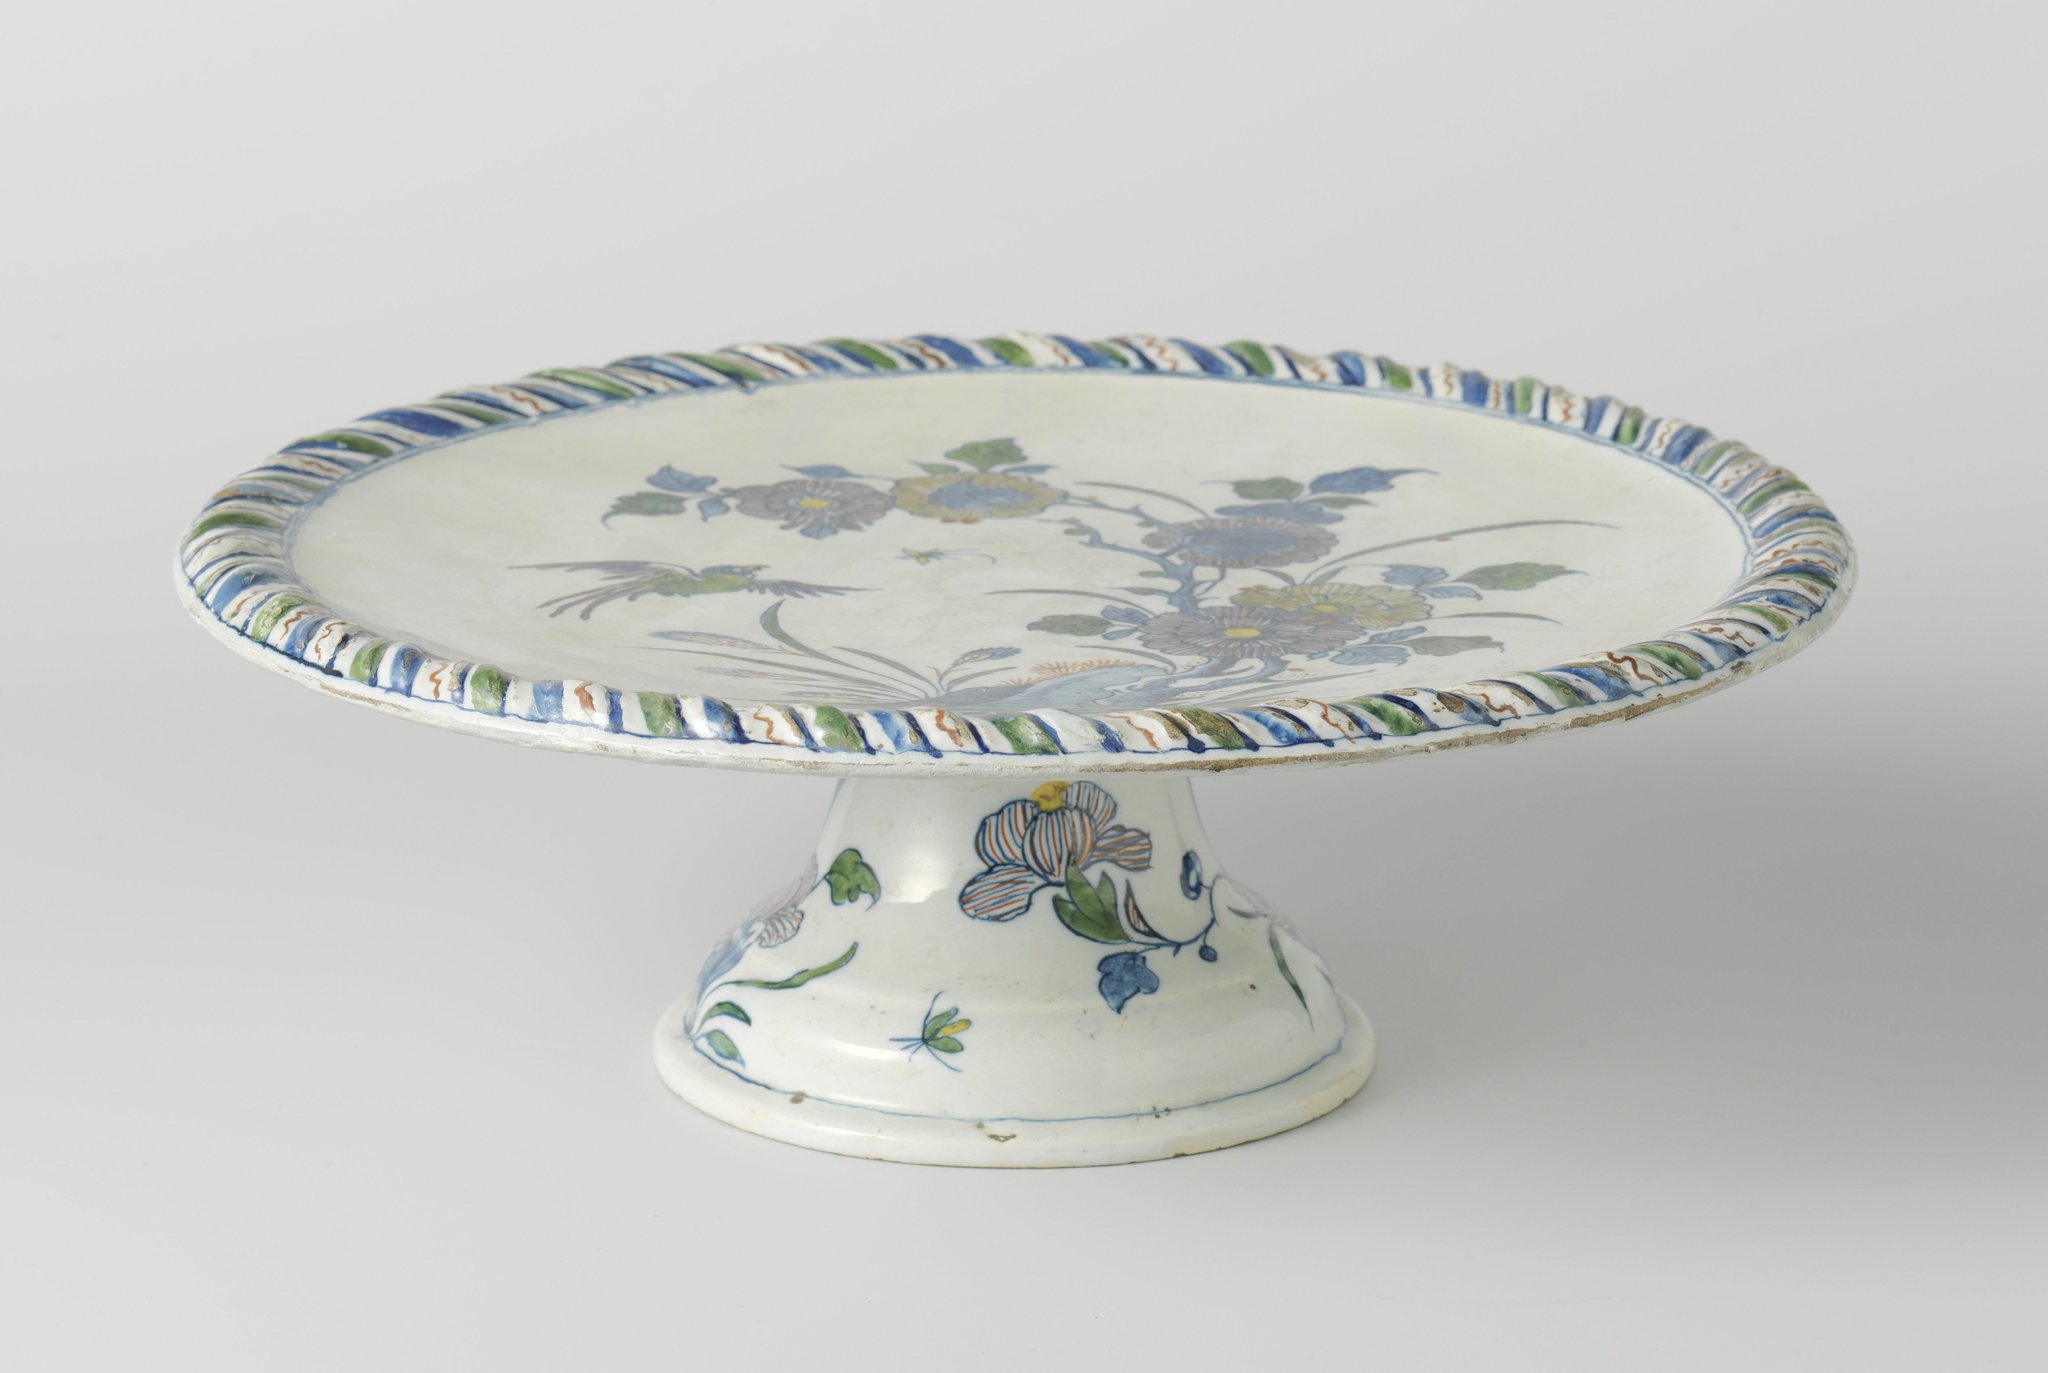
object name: cake plate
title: Gebakschaal, rond op voet, veelkleurig beschilderd met bloemen en vliegende vogel.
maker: cornelis koppens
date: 1700-1725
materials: earthenware, glaze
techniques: painted, polychromy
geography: delft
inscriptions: mark: ‘11’, mark: ‘CK (ineen)/ 10/ 0’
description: Ronde taartschaal op een voet, van veelkleurig beschilderde faience. Op het plat is een plant met bloemen op een grond en een vliegende vogel geschilderd. De rand is gestreept en in relief. Op de voet zijn twee takken geschilderd. De gebruikte kleuren zijn: blauw, rood en groen. De schaal is gemerkt met de letters CK.